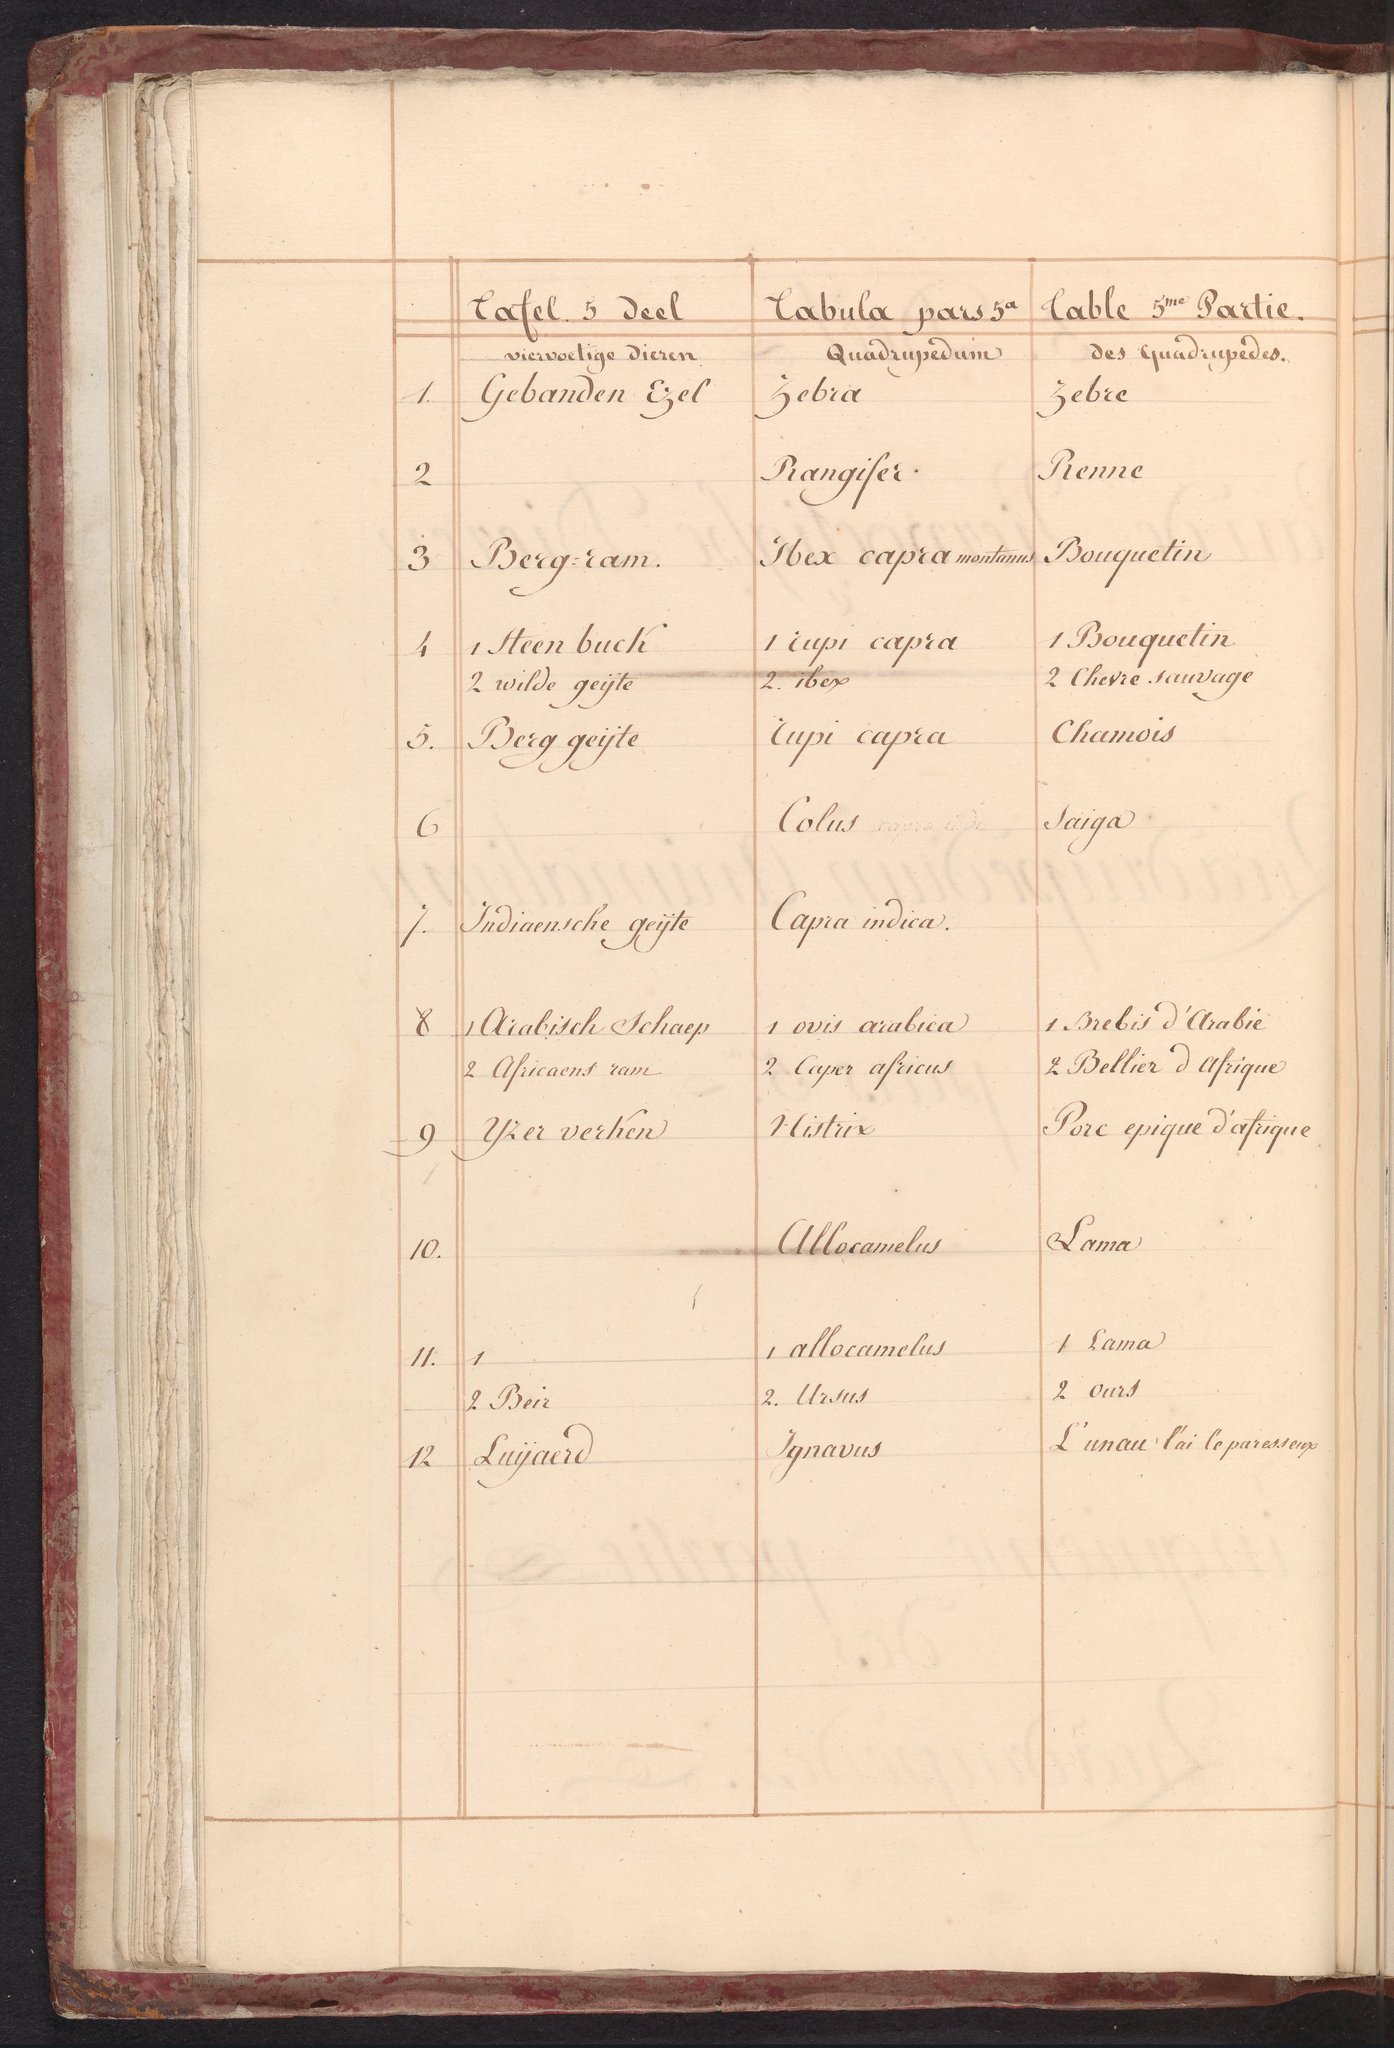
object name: manuscript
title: Lijst van dieren in vijfde deel van de viervoeters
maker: joseph van huerne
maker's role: kunstliefhebber, mecenas, verzamelaar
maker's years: 1752-1844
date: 1809-1814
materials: ink, paper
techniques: handwriting, pen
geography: bruges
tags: handwriting, written text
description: Schema met een lijst van dieren voorgesteld in het vijfde deel van de viervoeters: nummers 1-12. Onderdeel van het tweede album met tekeningen van viervoeters. Tweede van twaalf albums met tekeningen van dieren, vogels en planten bekend rond 1600, gemaakt in opdracht van keizer Rudolf II. Met toelichting in Nederlands, Latijn en Frans.